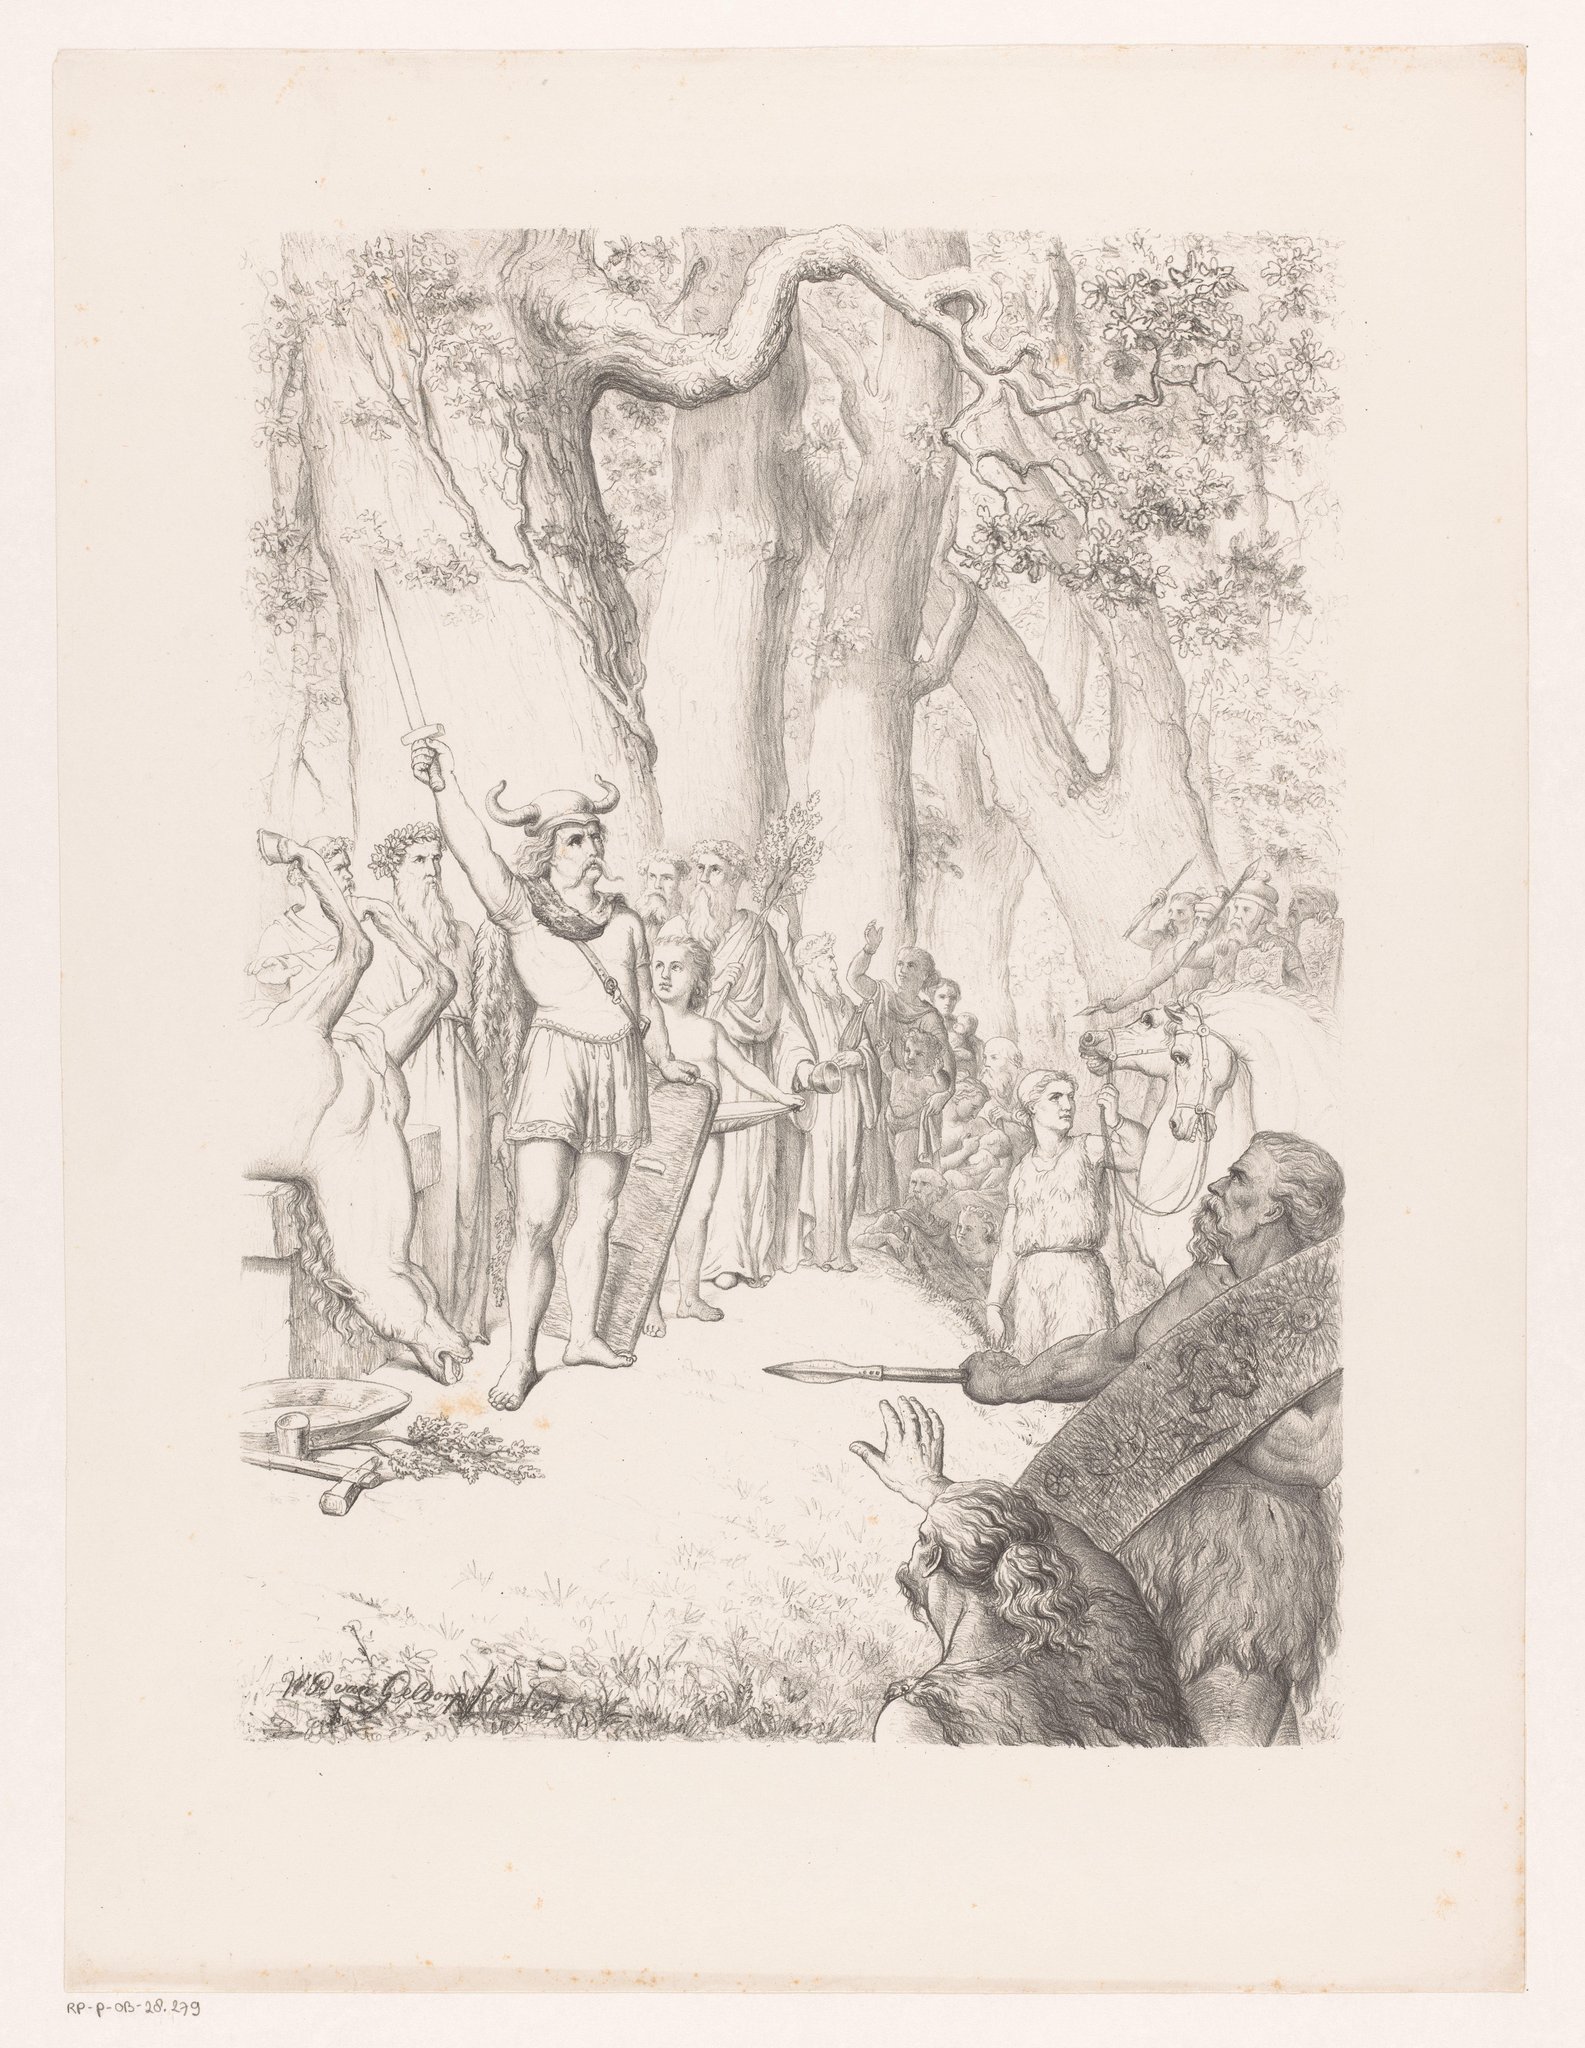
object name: print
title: Kunst-Album door W. P. van Geldorp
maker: wilhelmus petrus van geldorp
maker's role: print maker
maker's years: 1832-1900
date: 1869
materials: paper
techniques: lithograph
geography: rotterdam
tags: the oath of julius claudius civilis: during a meal he induces his people to revolt against the romans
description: Claudius Civilis, leider van de Bataven, staat te midden van zijn volk. Hij heeft zijn zwaard in de lucht gestoken. Links van hem ligt een geofferd paard.